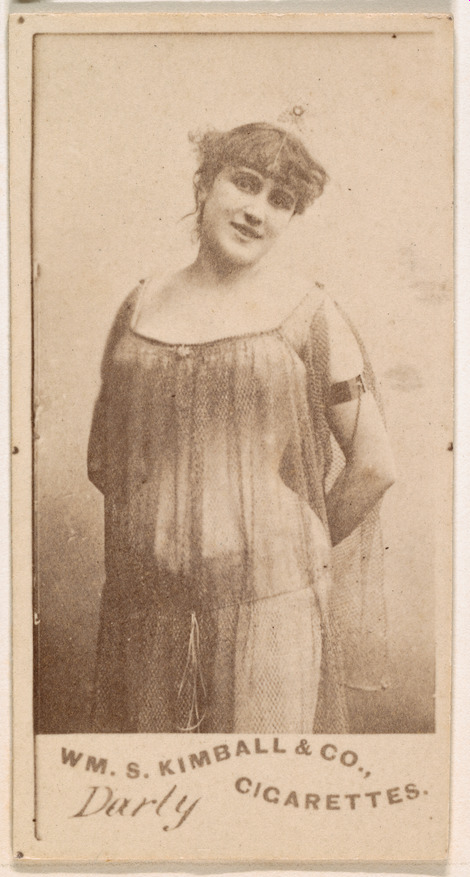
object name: photograph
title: Miss Darly, from the Actresses series (N203) issued by Wm. S. Kimball & Co.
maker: william s. kimball & company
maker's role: publisher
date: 1889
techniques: color lithograph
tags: portraits,women,actresses